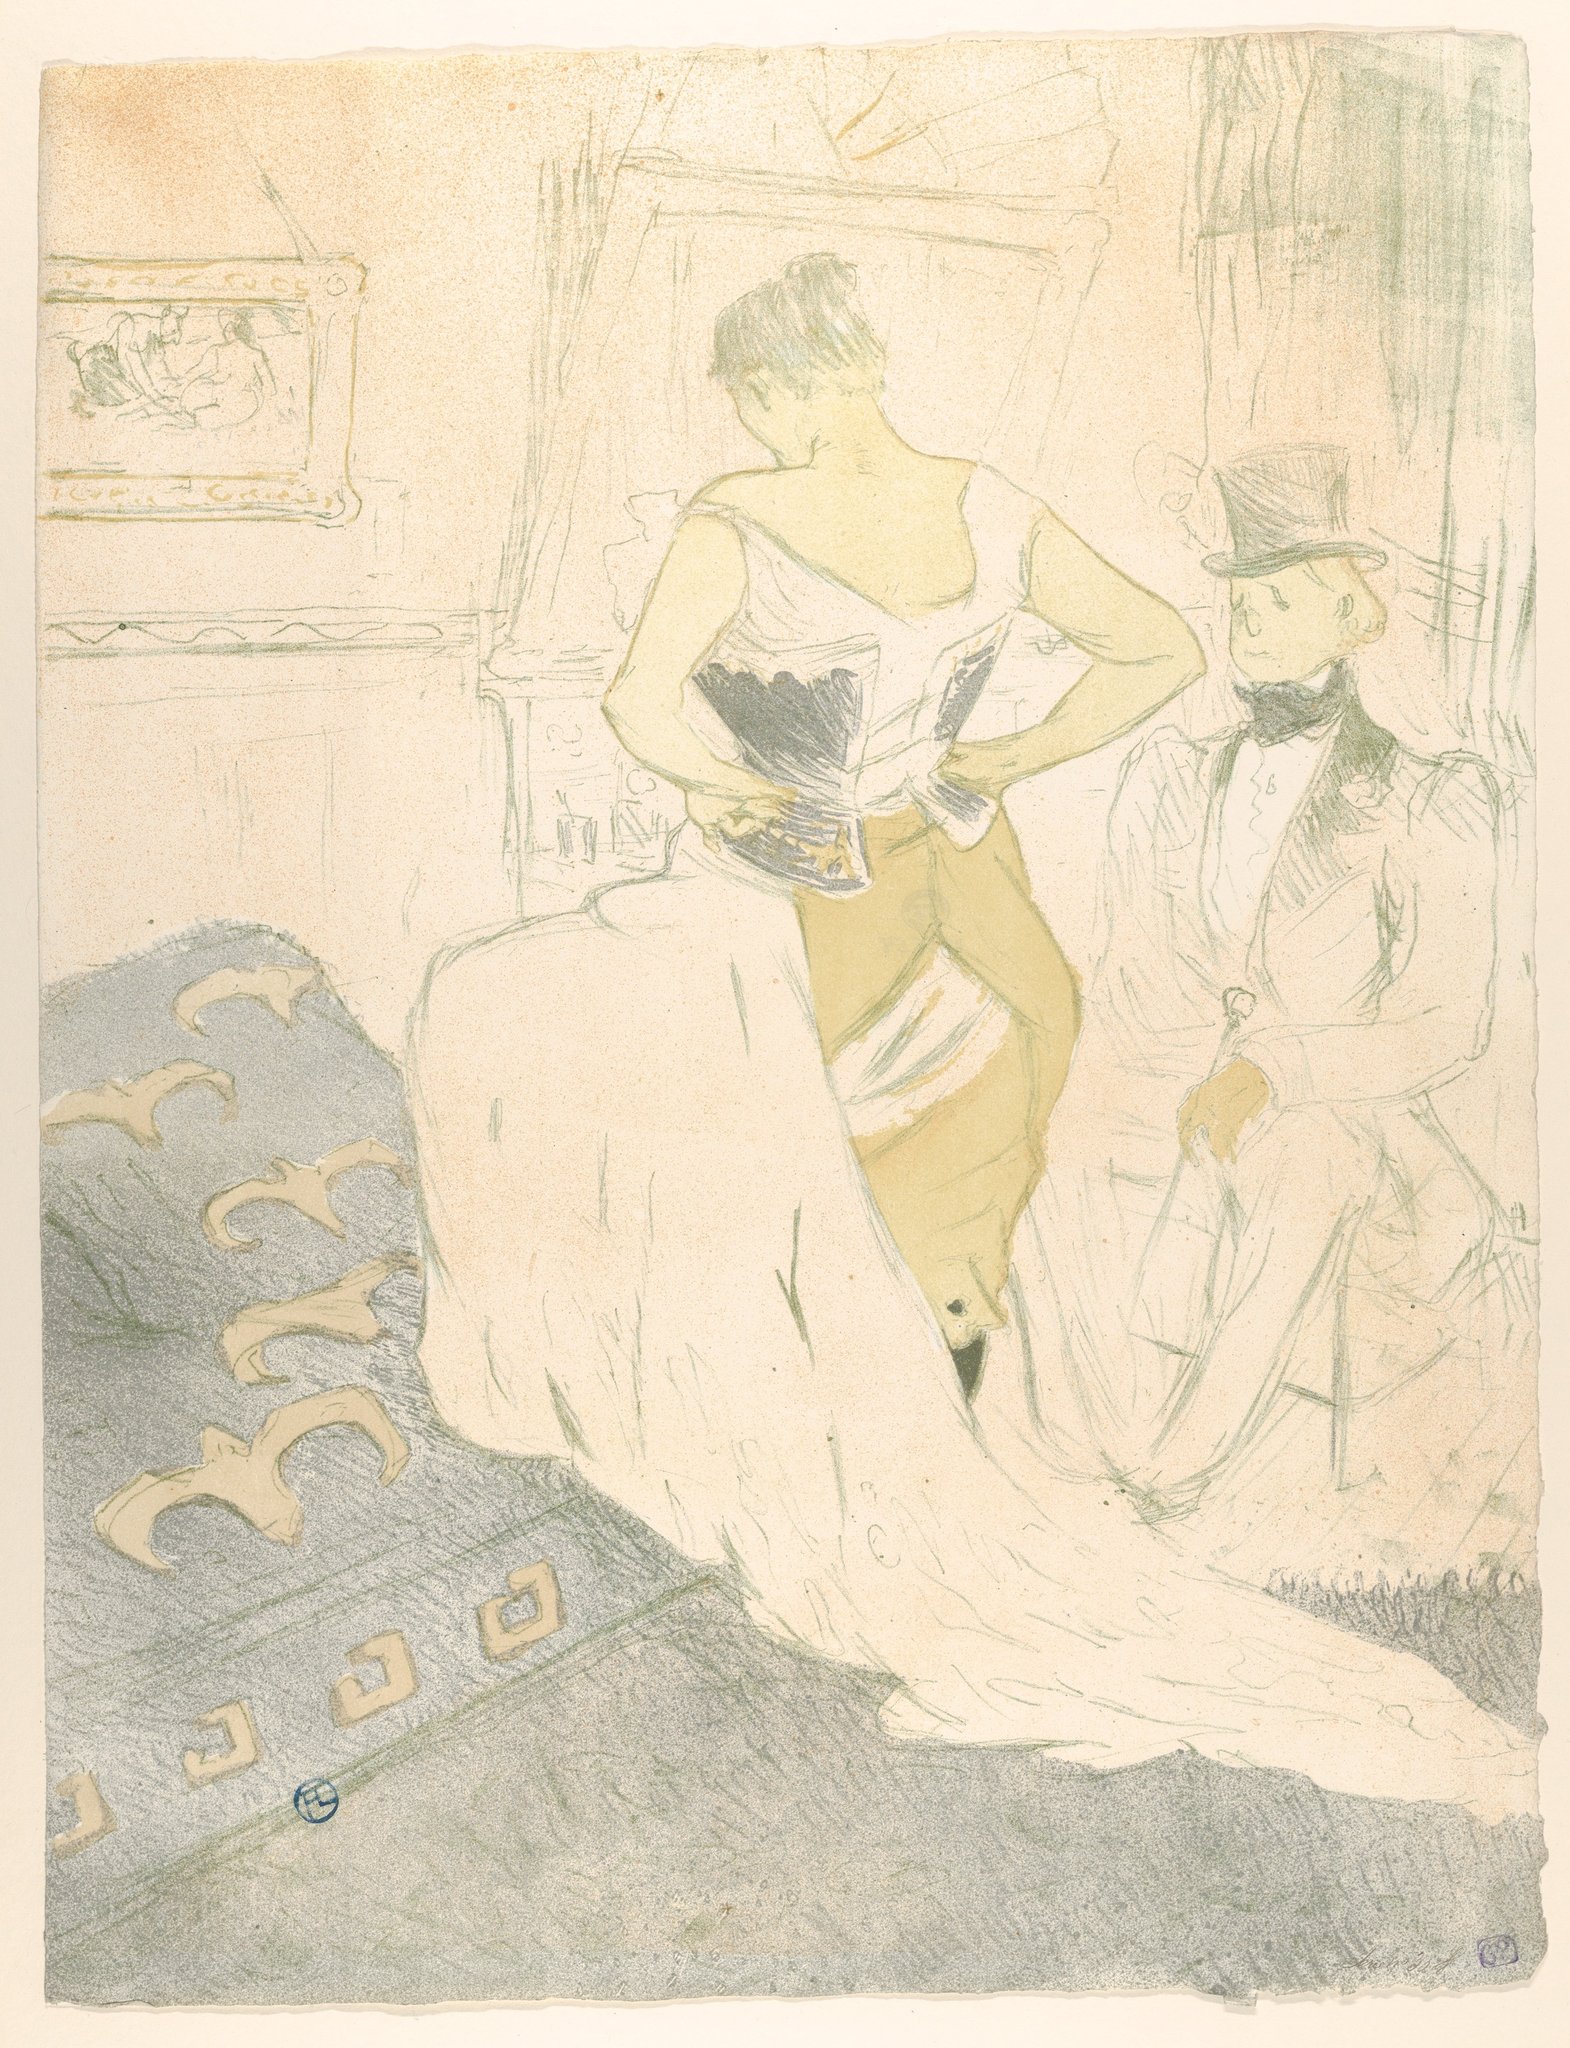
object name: print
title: Fastening a Corset – A Passing Conquest, from "Elles"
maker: henri de toulouse-lautrec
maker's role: artist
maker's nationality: french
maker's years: 1864-1901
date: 1896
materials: crayon, paper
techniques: brush, lithograph, printing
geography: france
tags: men,women,dressing